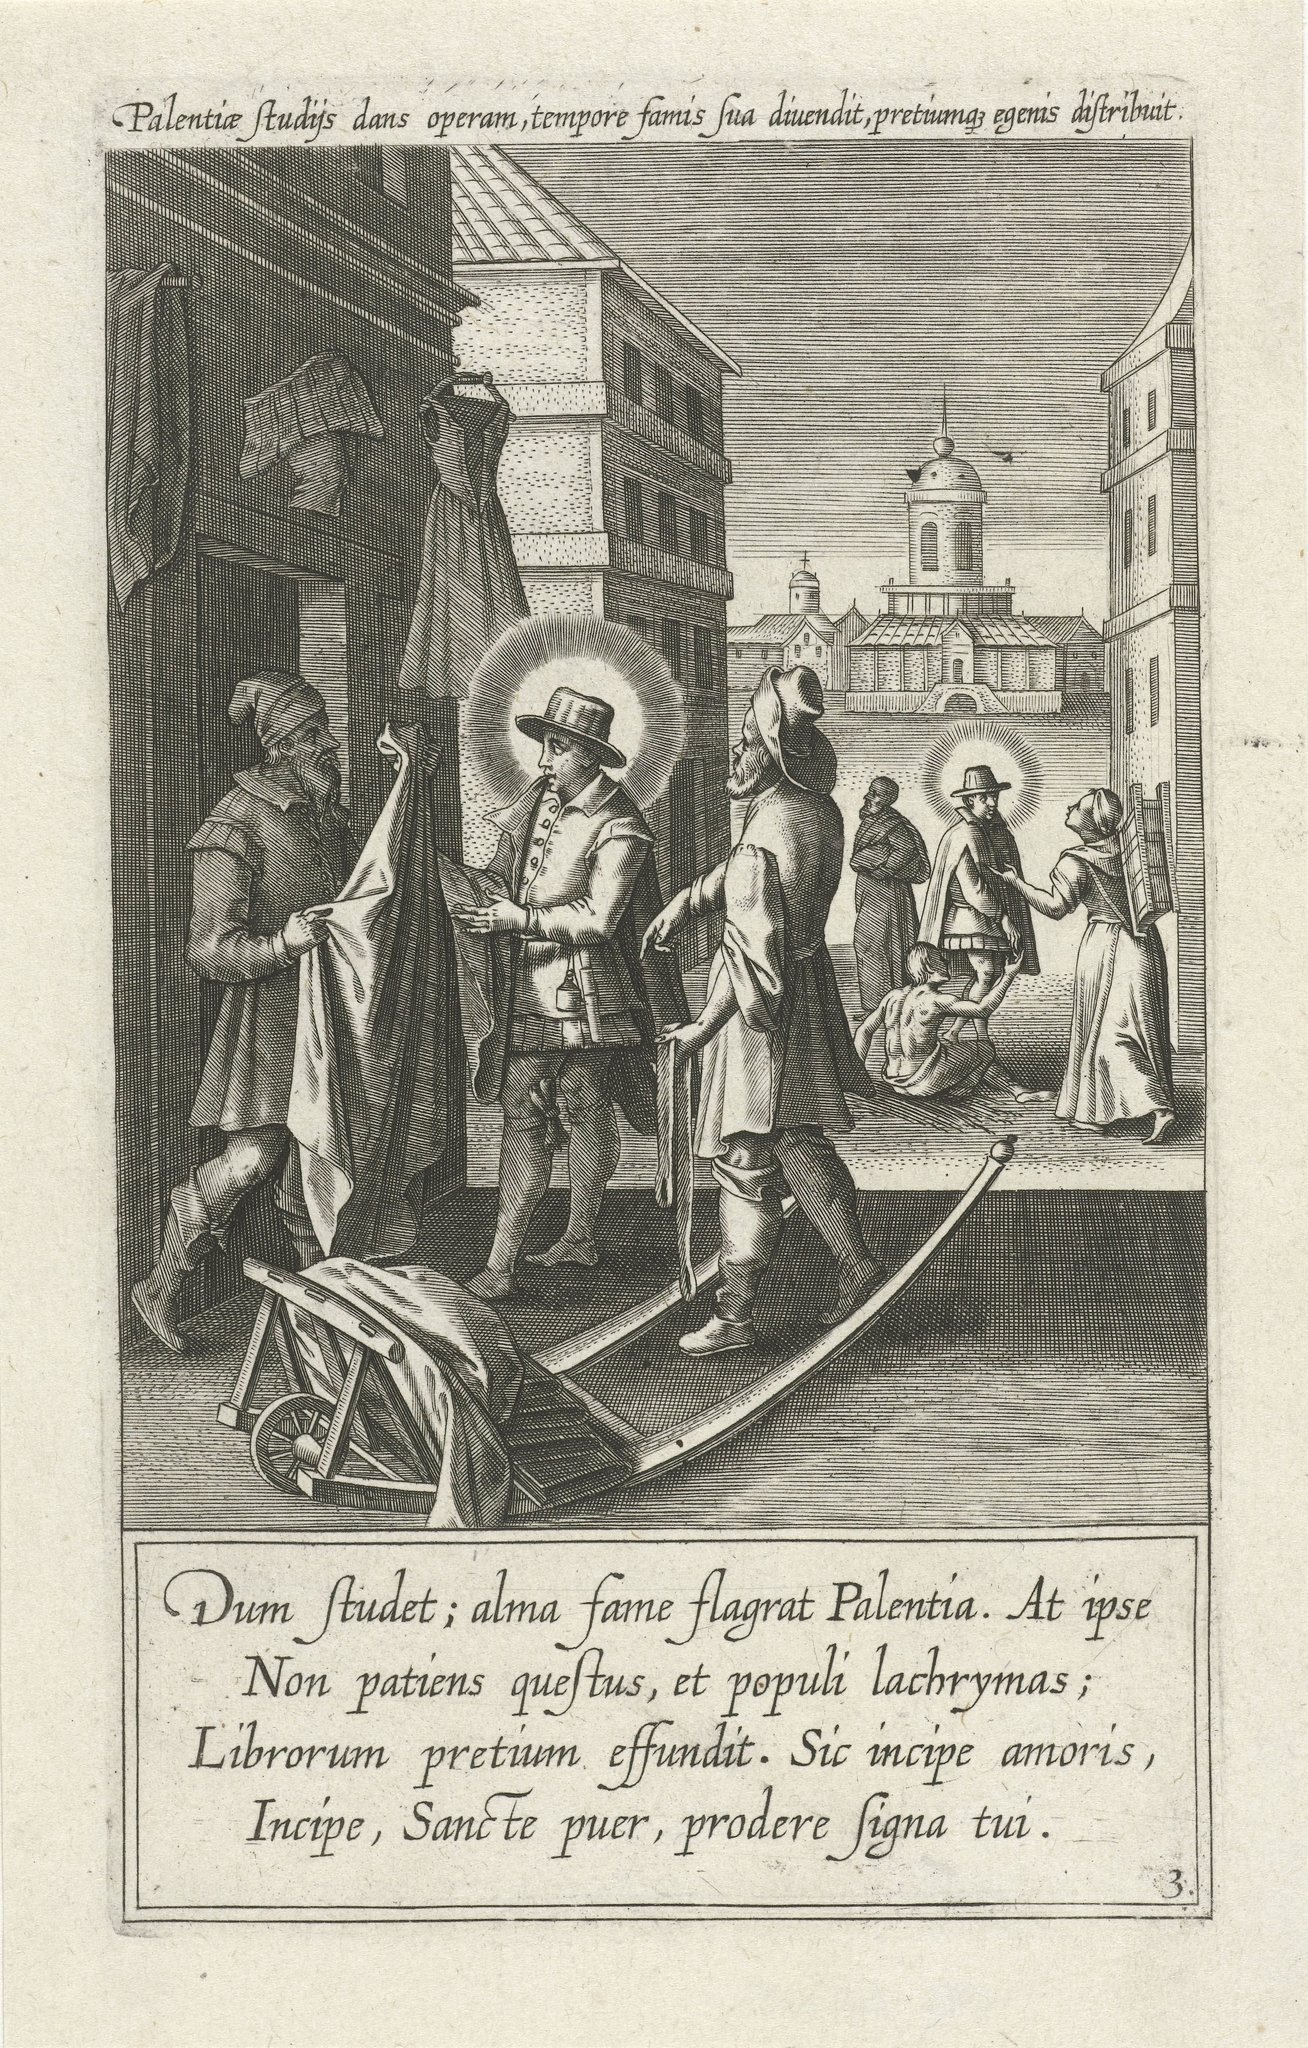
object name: print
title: Vita et miracula S.P. Dominici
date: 1611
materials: paper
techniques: engraving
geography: antwerp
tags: st. dominic as a young student sells his books to help the sick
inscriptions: collector's mark: Lugt 2228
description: Tijdens zijn studietijd verkoopt de heilige Dominicus al zijn bezittingen om de armen van de stad te helpen met aalmoezen. De prent heeft een Latijns opschrift en onderschrift en maakt deel uit van een prentserie voor een boek over het leven van de heilige Dominicus.